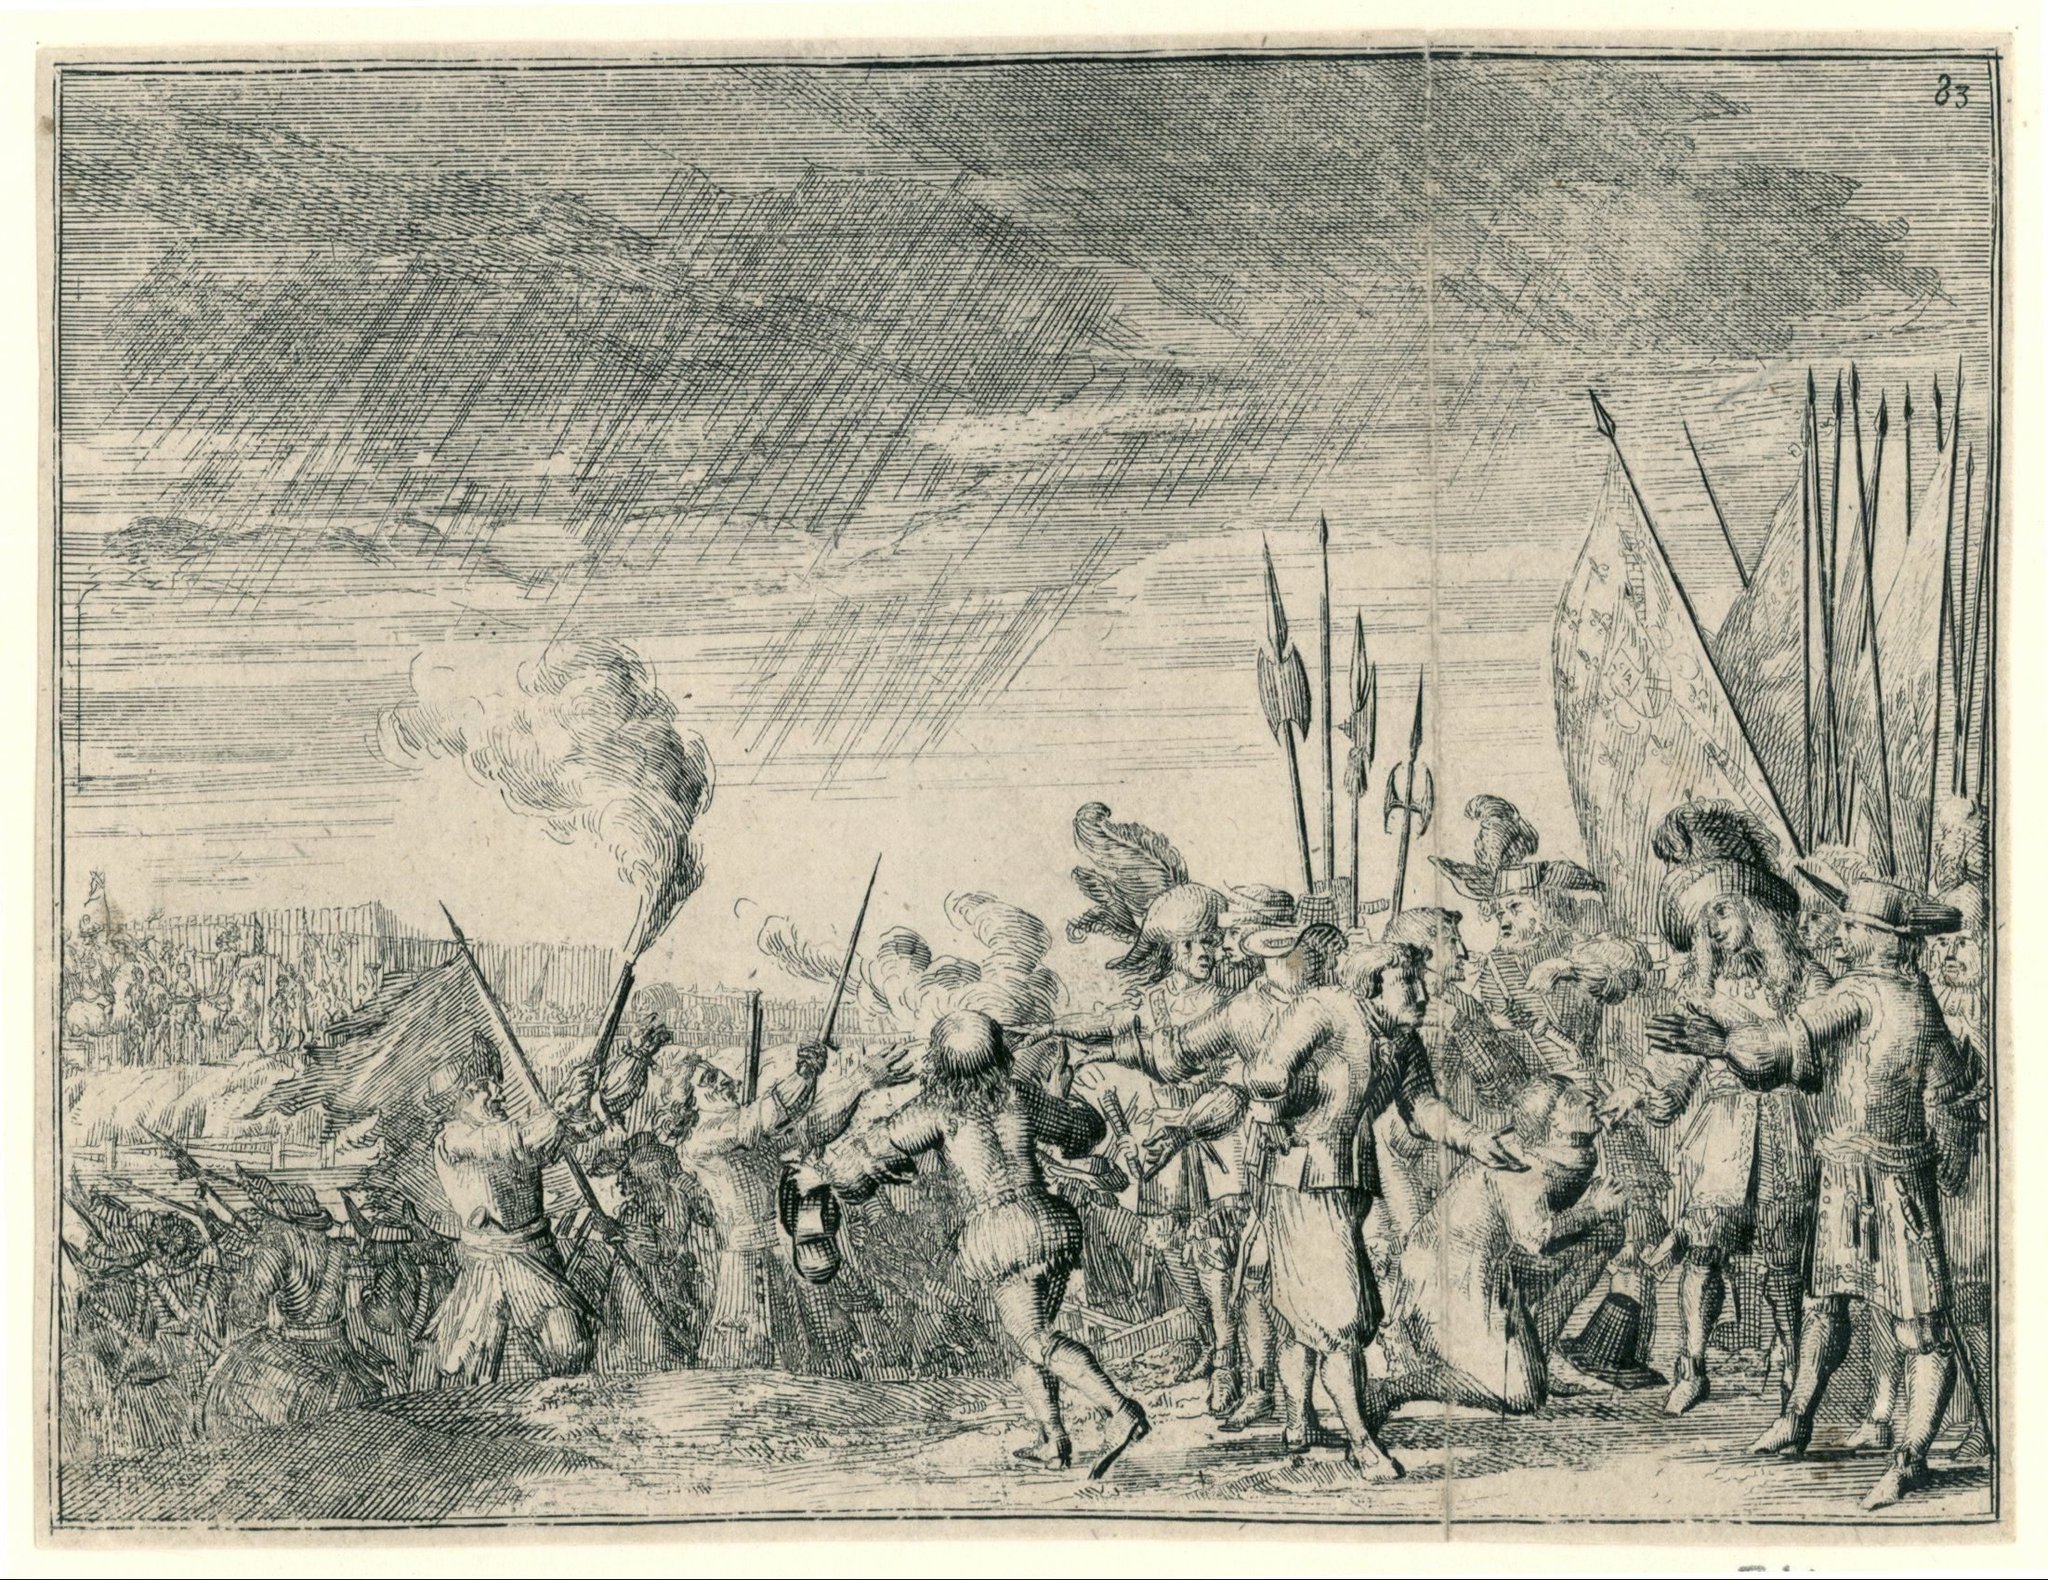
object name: print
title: Smeekbeden van burgers aan een Franse veldheer, 1672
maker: Anonymous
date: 1673-1674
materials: paper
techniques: engraving, etching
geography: northern netherlands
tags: bodegraven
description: Voorstelling van de wreedheden bedreven door de Franse troepen in Hollandse dorpen in het jaar 1672, gekopieerd naar de prent van Romeyn de Hooghe uit 1673 (FM 2439/2). In de voorstelling knielen, buiten de stad, verschillende personen voor een Franse veldheer met zijn officieren. Rechtsboven het cijfer 83.